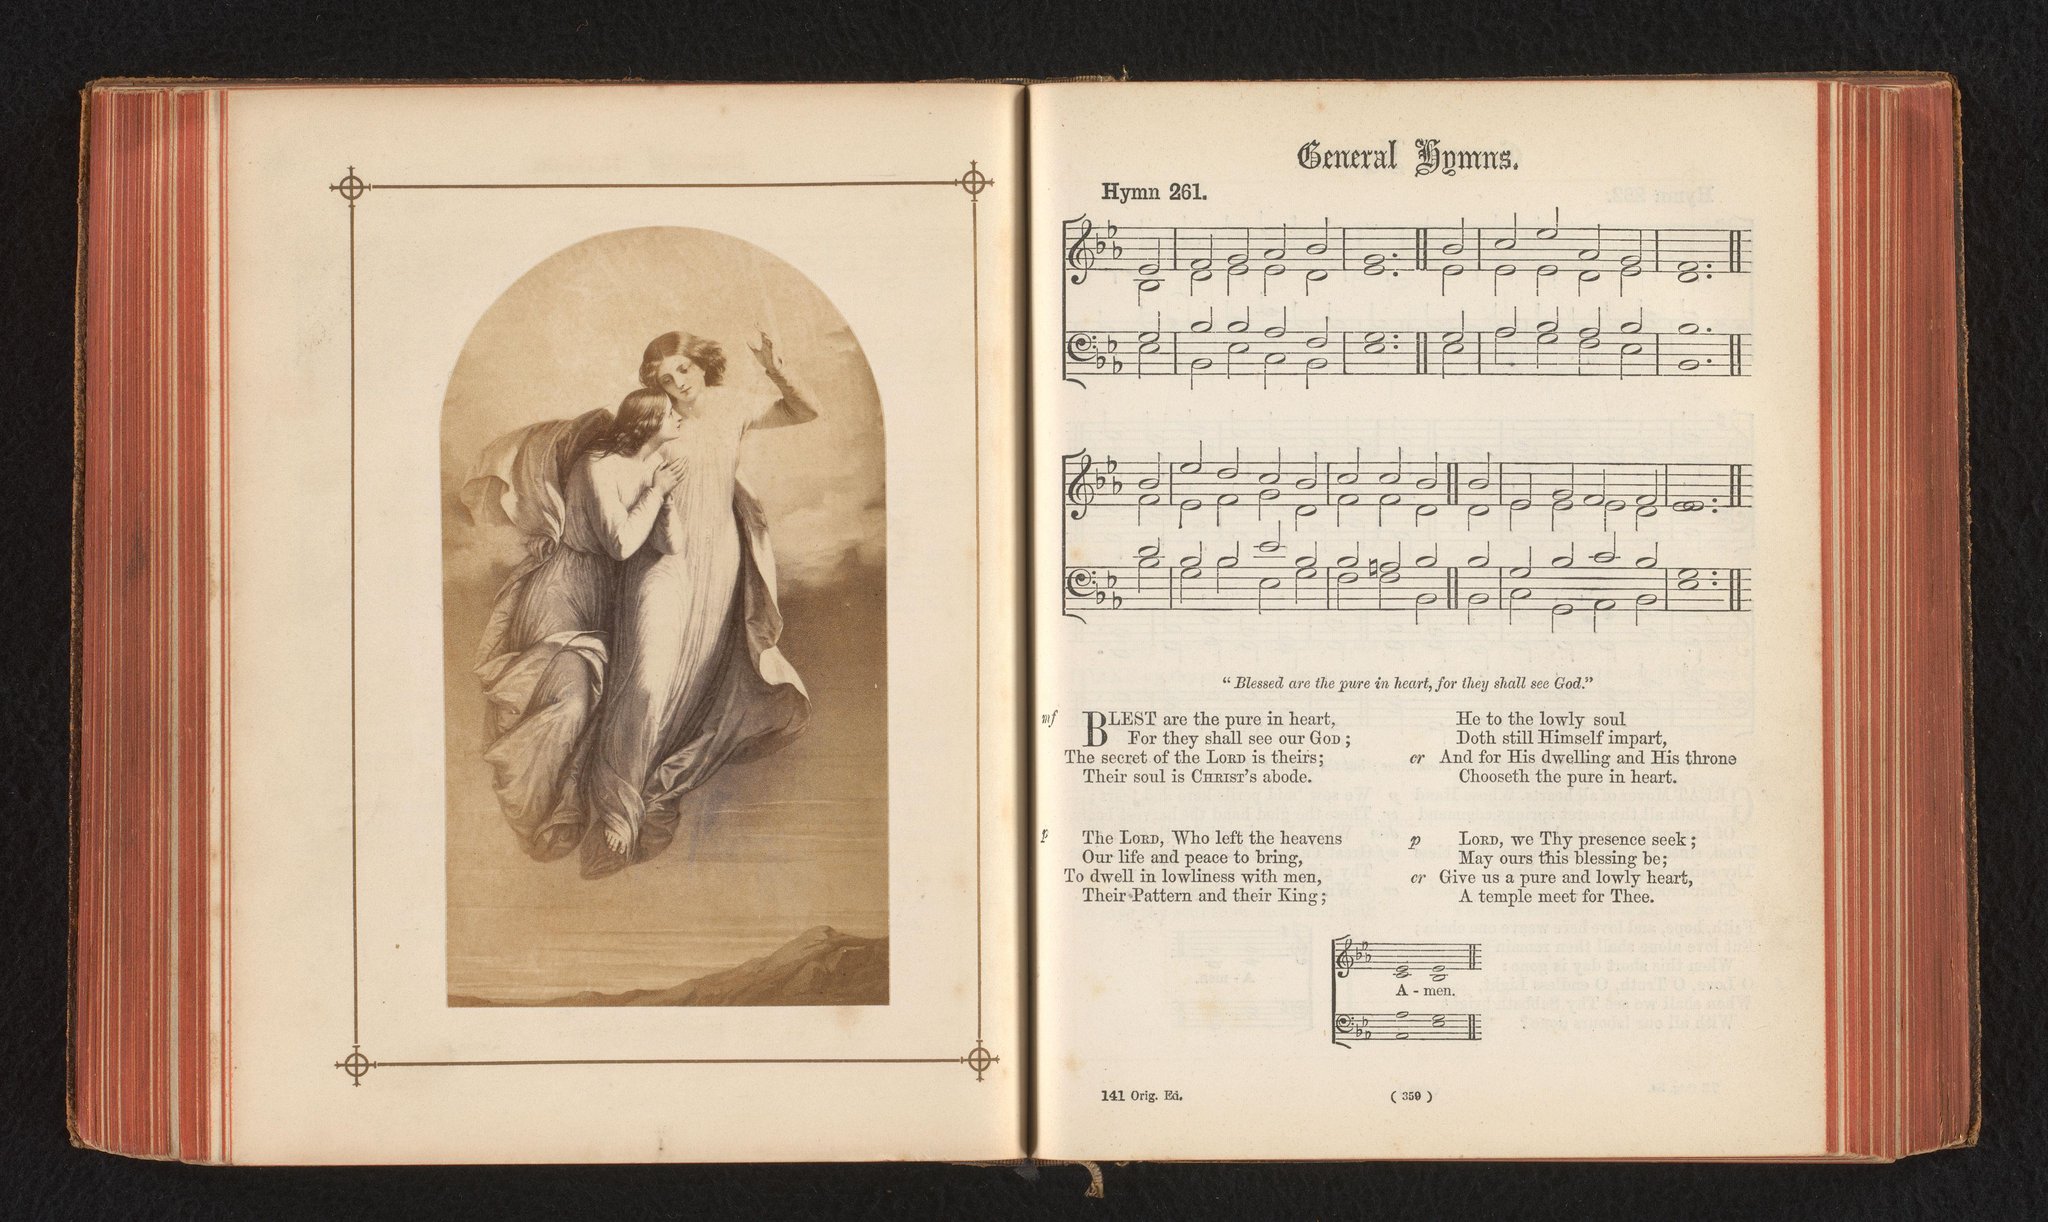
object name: page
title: Fotoreproductie van een schilderij van twee engelen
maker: Anonymous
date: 1866-1876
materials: paper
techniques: albumen print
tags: picture, painting, angels